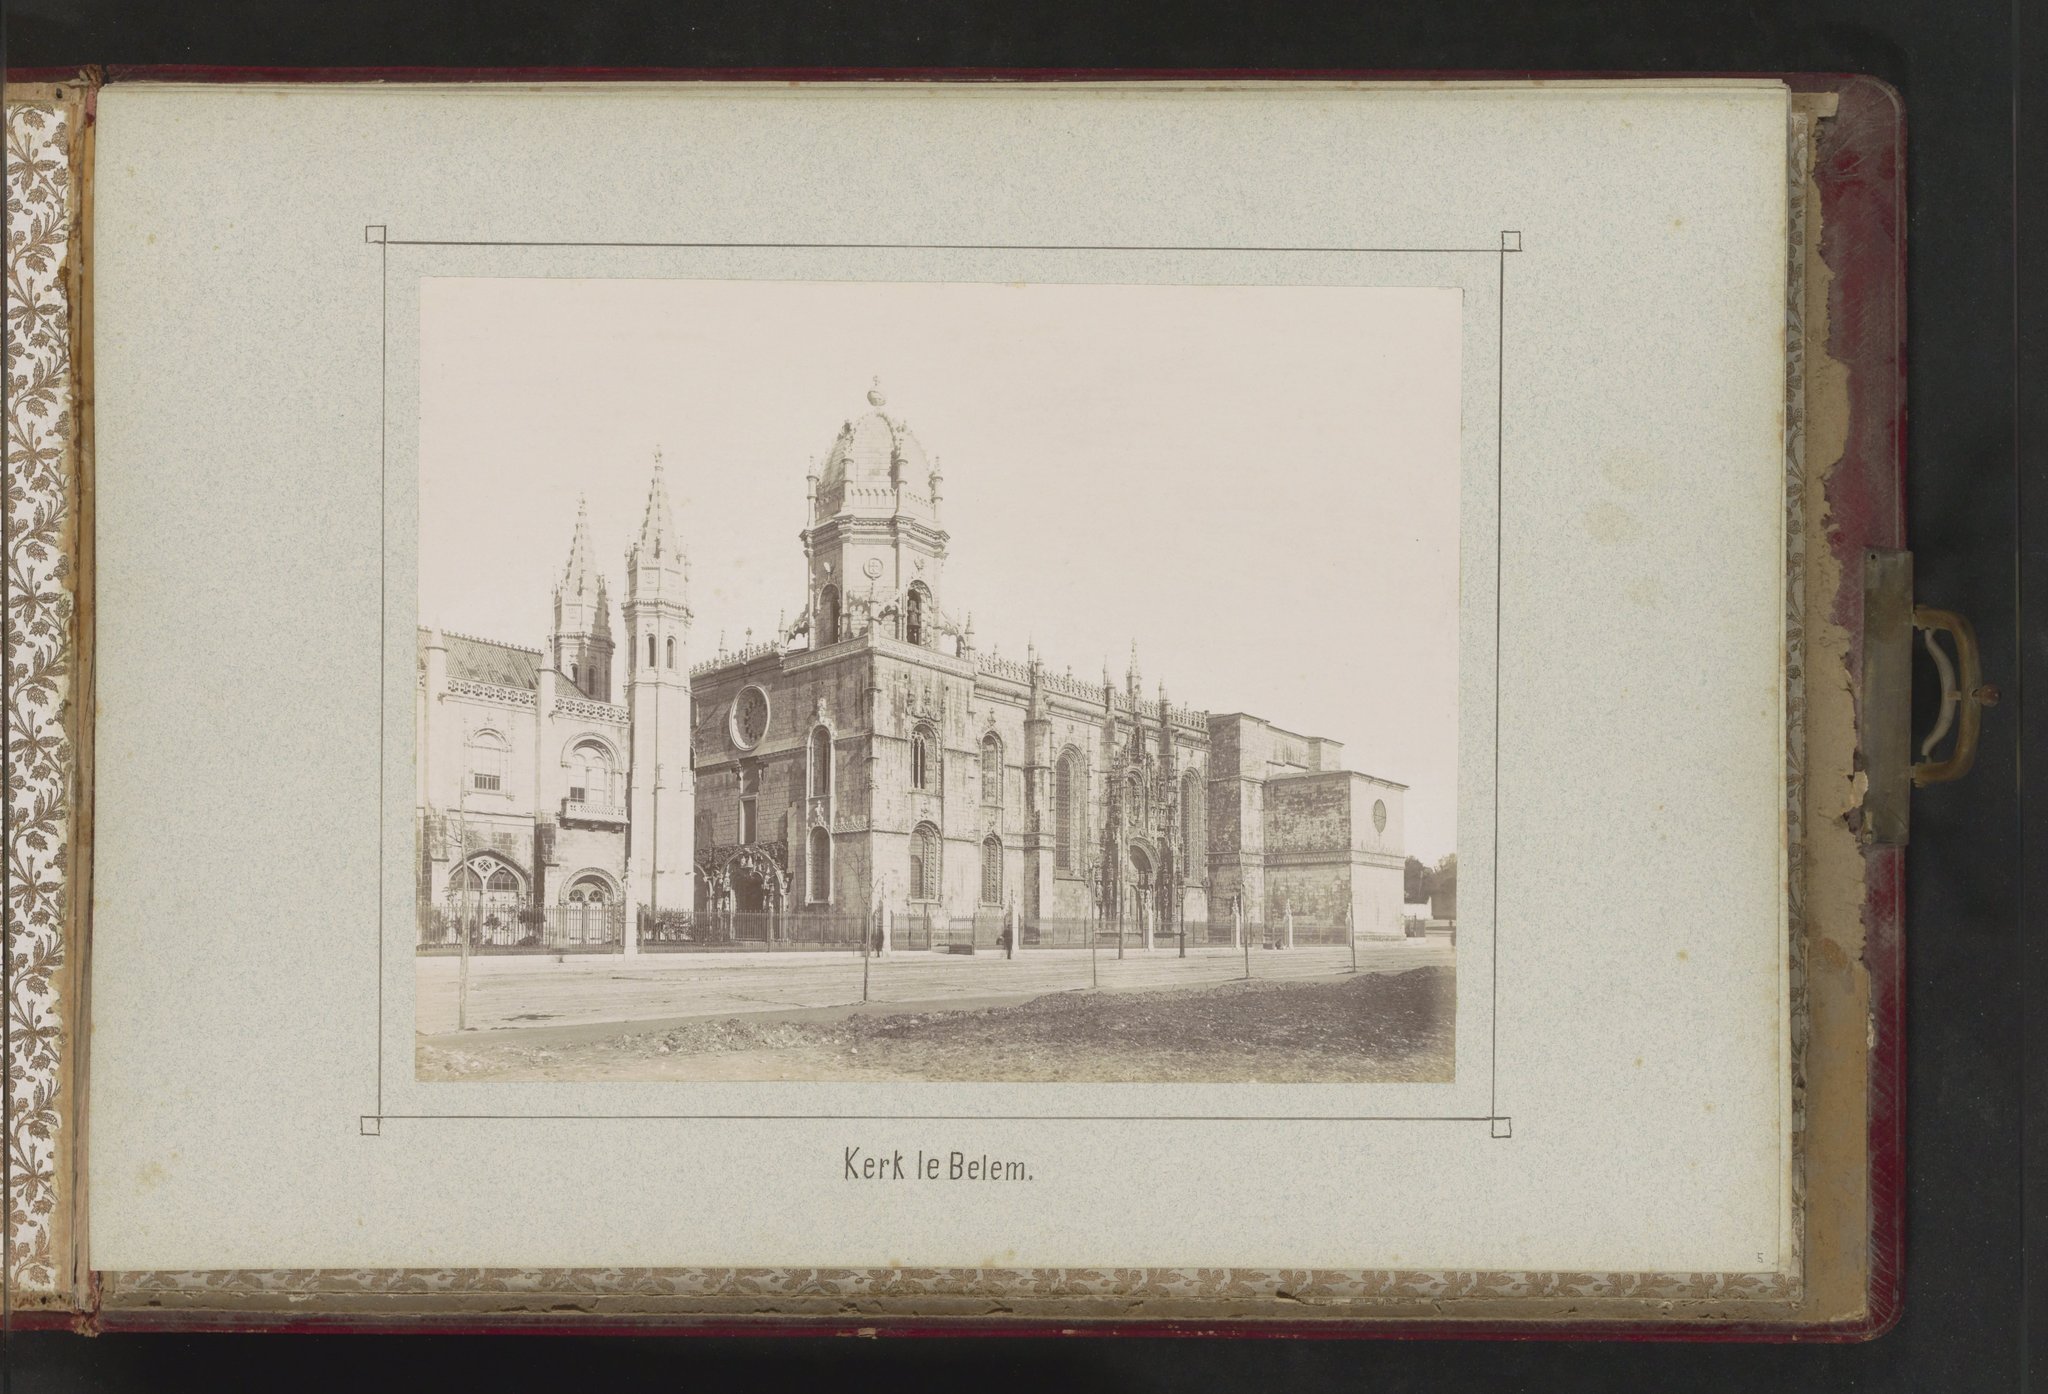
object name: photograph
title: Gezicht op het Mosteiro dos Jerónimos (Hiëronymietenklooster) in de wijk Belém te Lissabon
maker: Anonymous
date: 1880-1900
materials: photographic support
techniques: albumen print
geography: lisbon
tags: abbey, monastery, convent ~ roman catholic church, façade (of house or building), dome ~ architecture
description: Onderdeel van Reisalbum met foto's van Zuid-Afrika, Madeira, Portugal, Frankrijk en Duitsland.